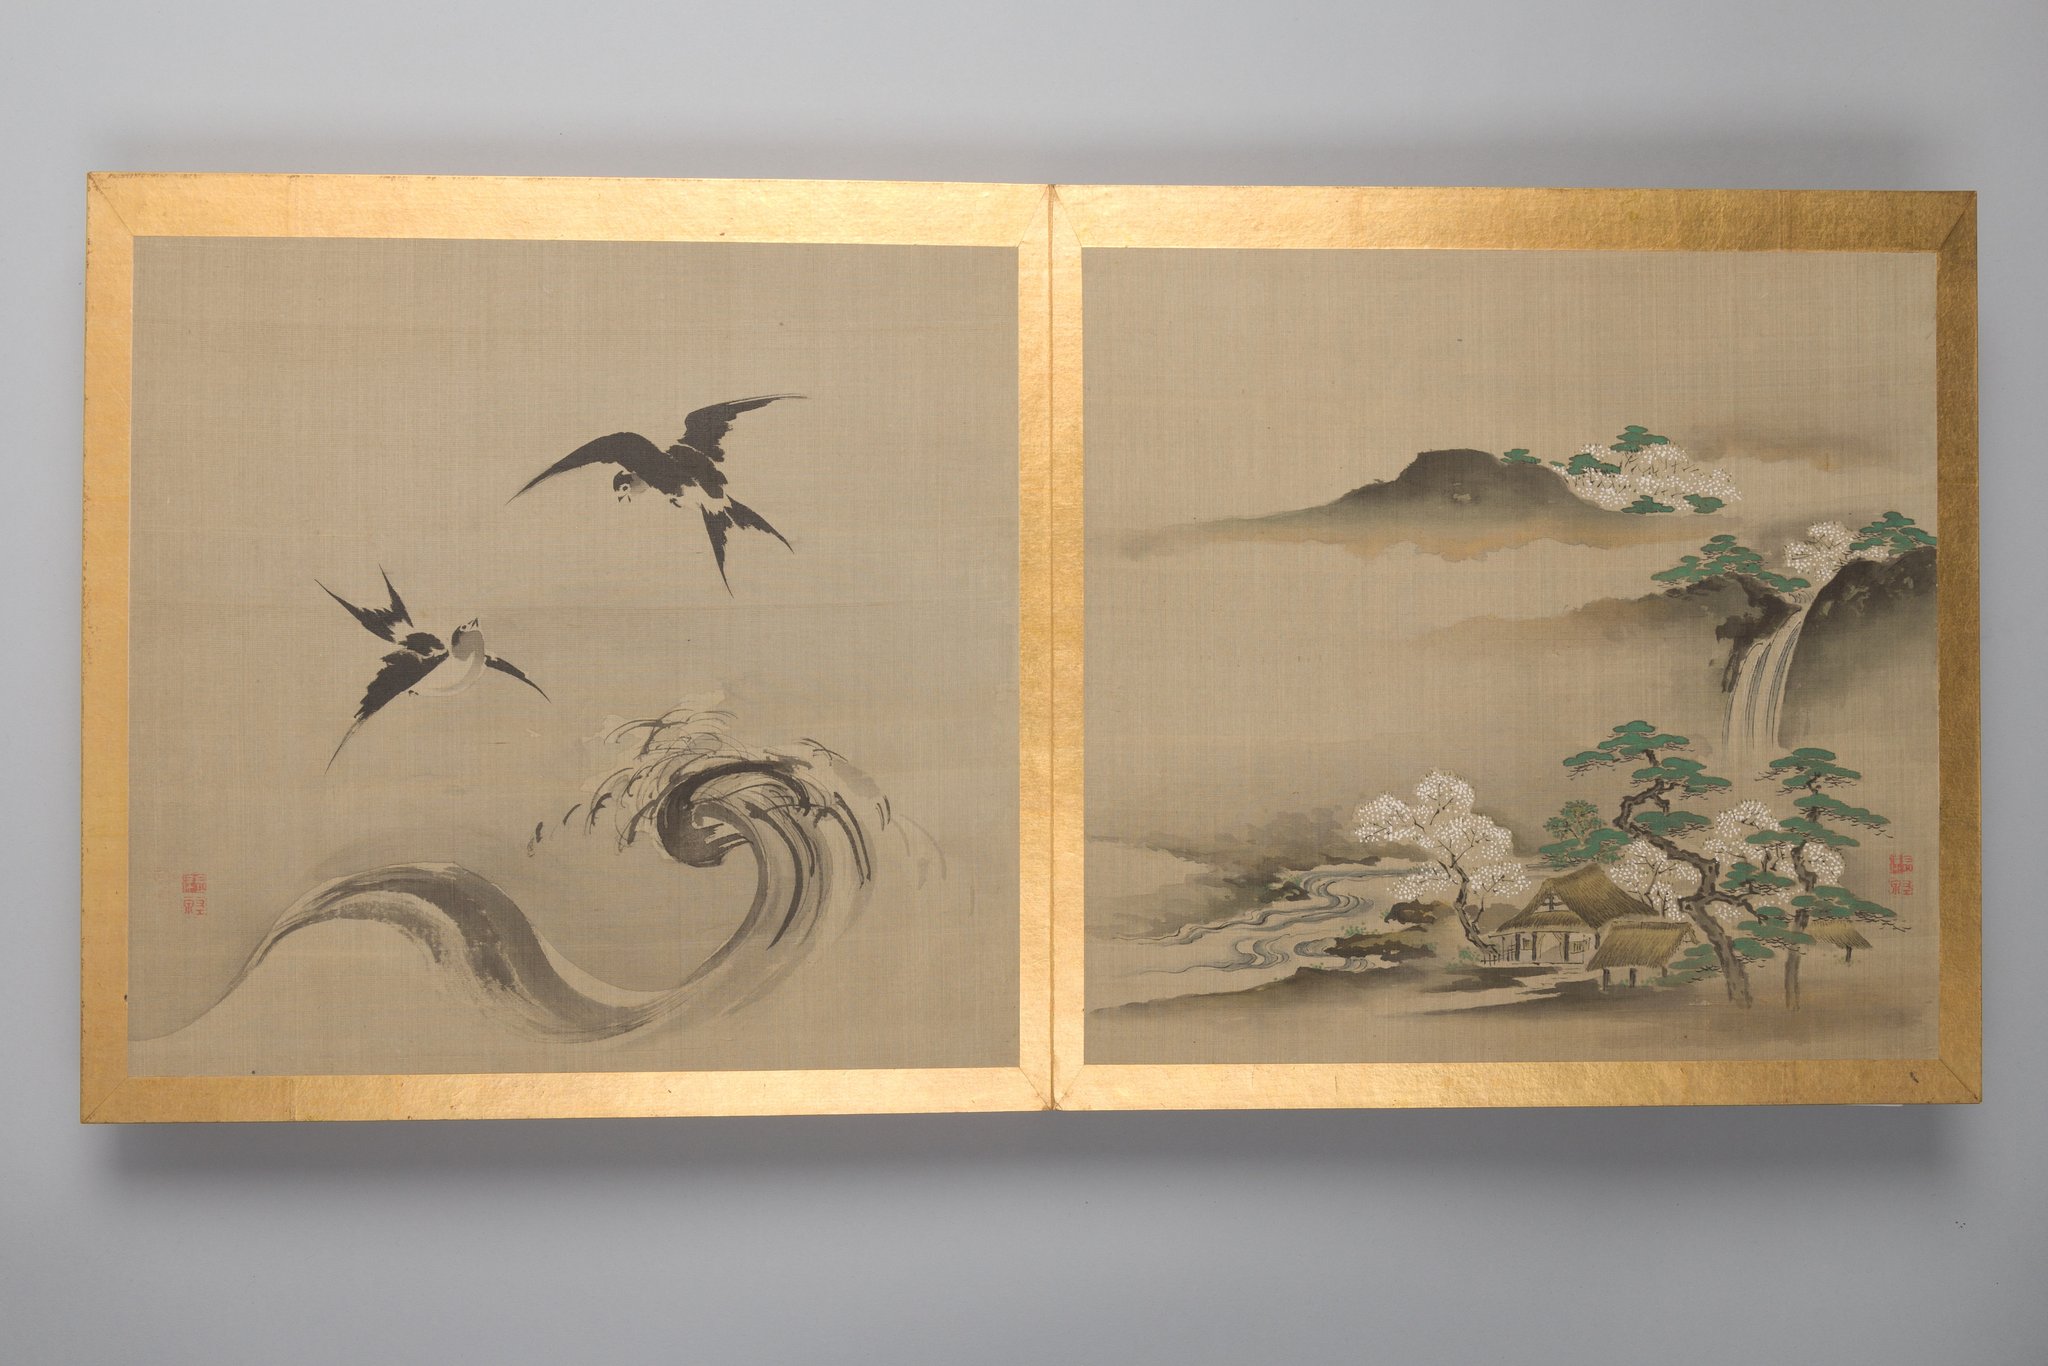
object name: album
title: Thirty paintings of birds, flowers and landscape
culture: japanese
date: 1767-1800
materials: silk